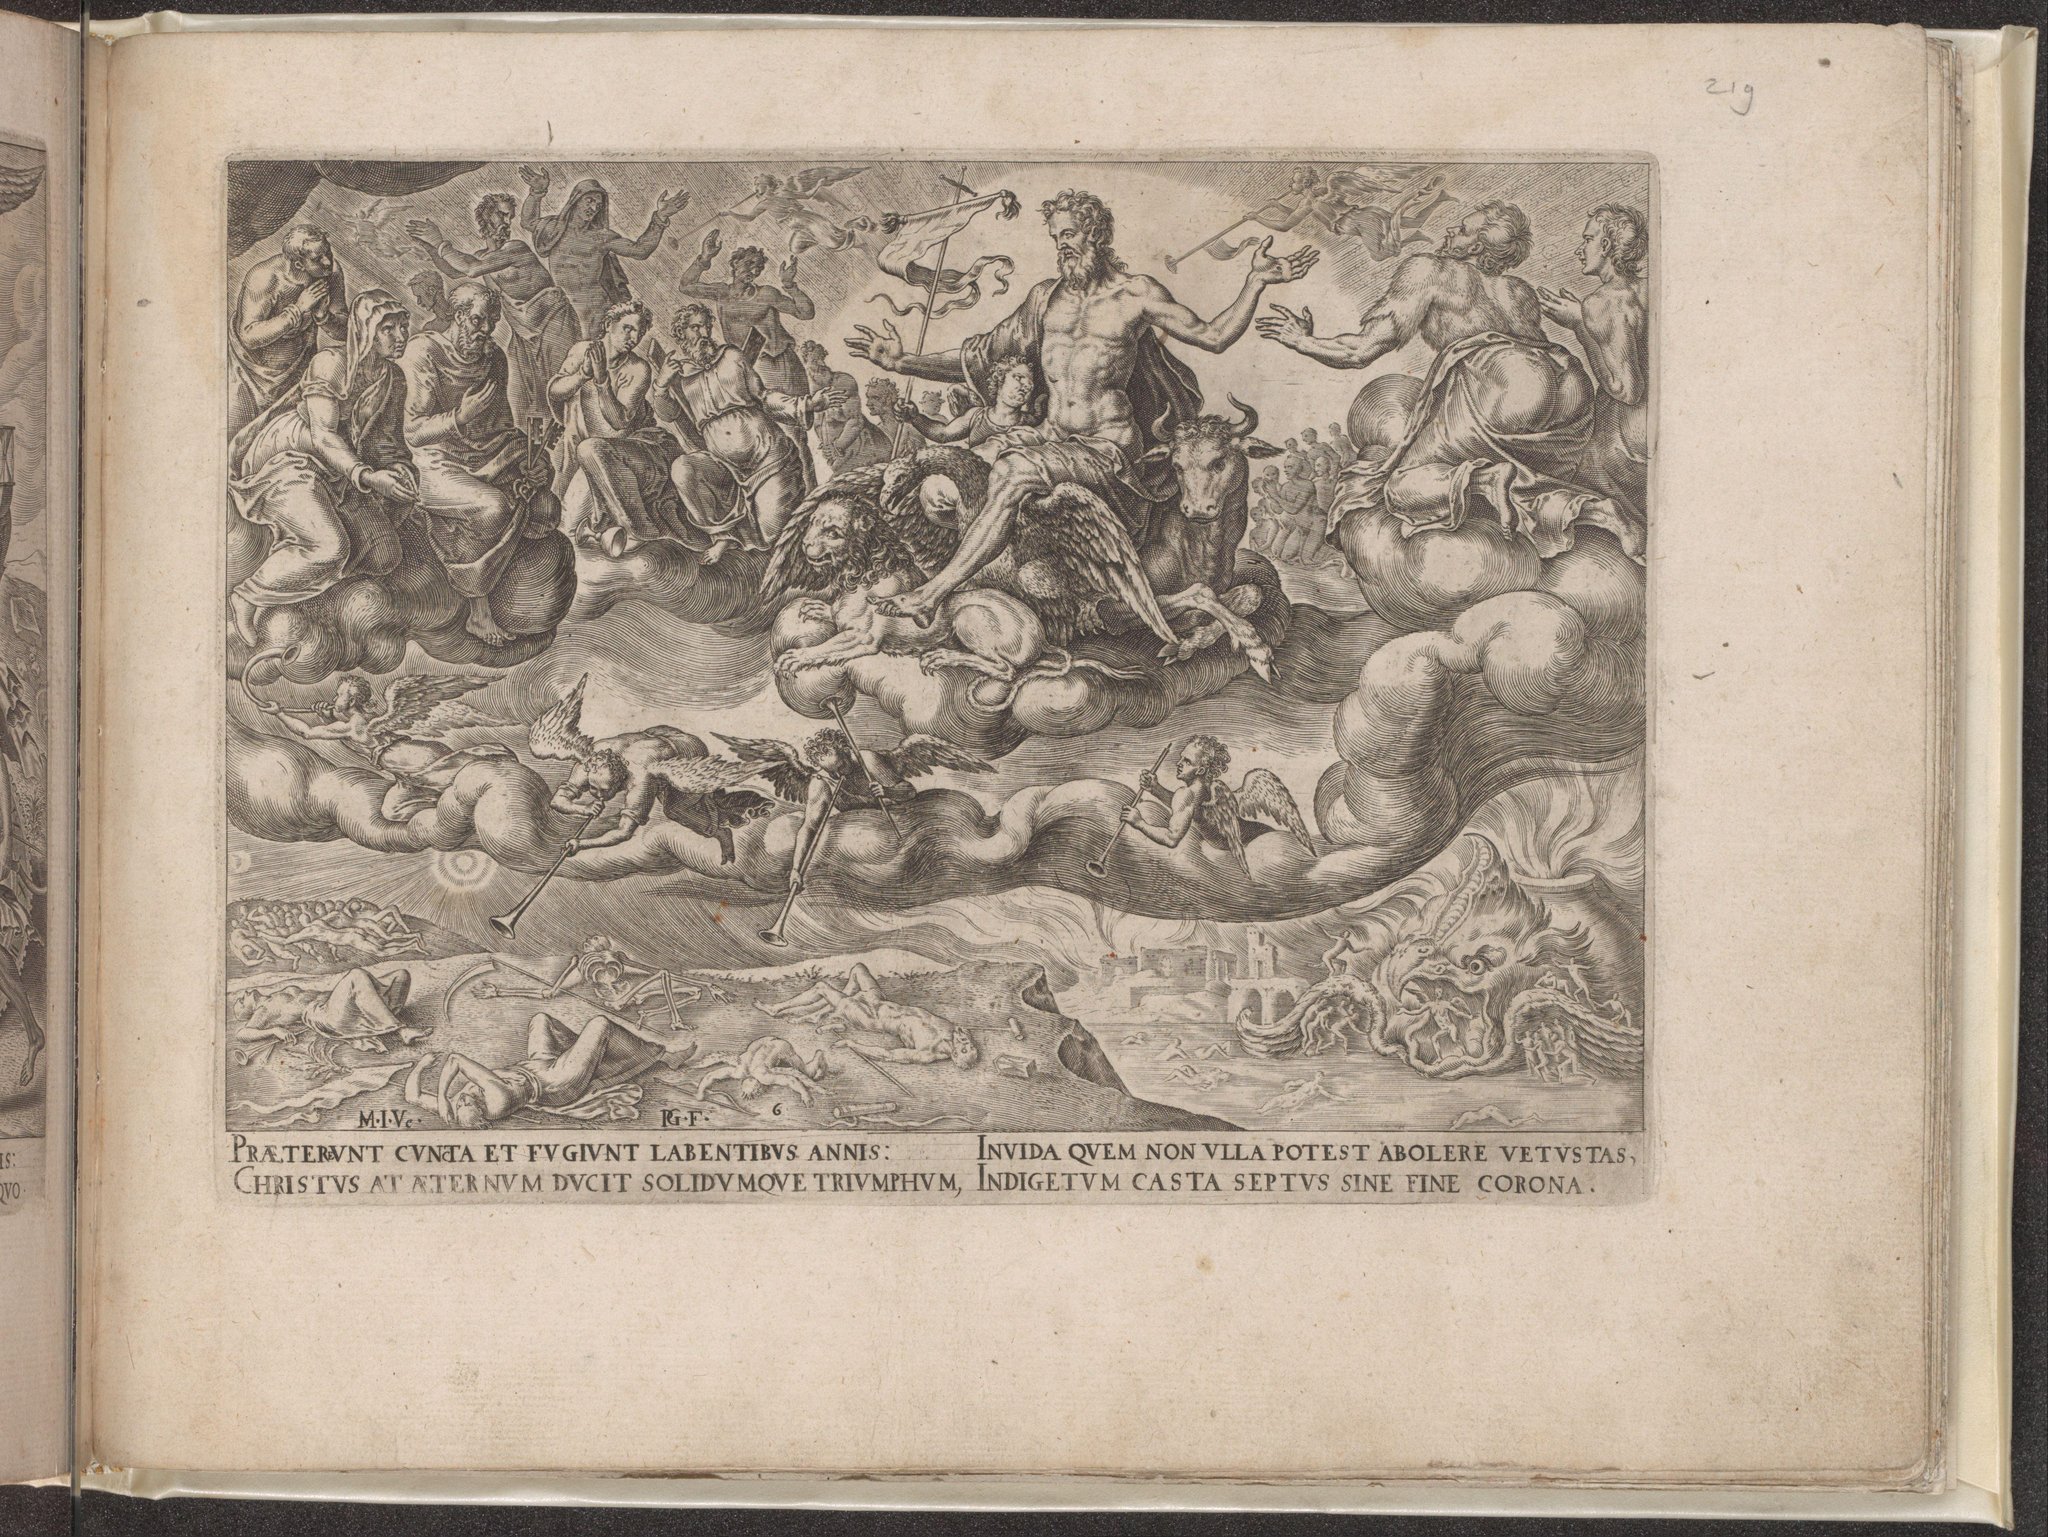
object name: album leaf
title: Triomf van Christus of de Eeuwigheid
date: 1563-1567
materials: paper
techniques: engraving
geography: haarlem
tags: last judgement, 'trionfo della divinità', 'triumphus aeternitatis'; 'carro della divinità', the four symbols of the evangelists, 'the apocalyptic beasts', entrance of hell as monstrous mouth (of leviathan)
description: Omringd door heiligen en apostelen troont Christus op de wolken. Hij wordt gedragen door een mens, een leeuw, een os en een adelaar, de symbolen van de vier evangelisten. Om hem heen in de wolken mensen in aanbidding. Beneden op aarde liggen de door Christus verslagen Liefde, Tijd, Faam, Kuisheid en de Dood. Rechtsonder de mond van de hel. Onder de voorstelling een verklarende tekst in het Latijn. Deze prent maakt deel uit van een album.